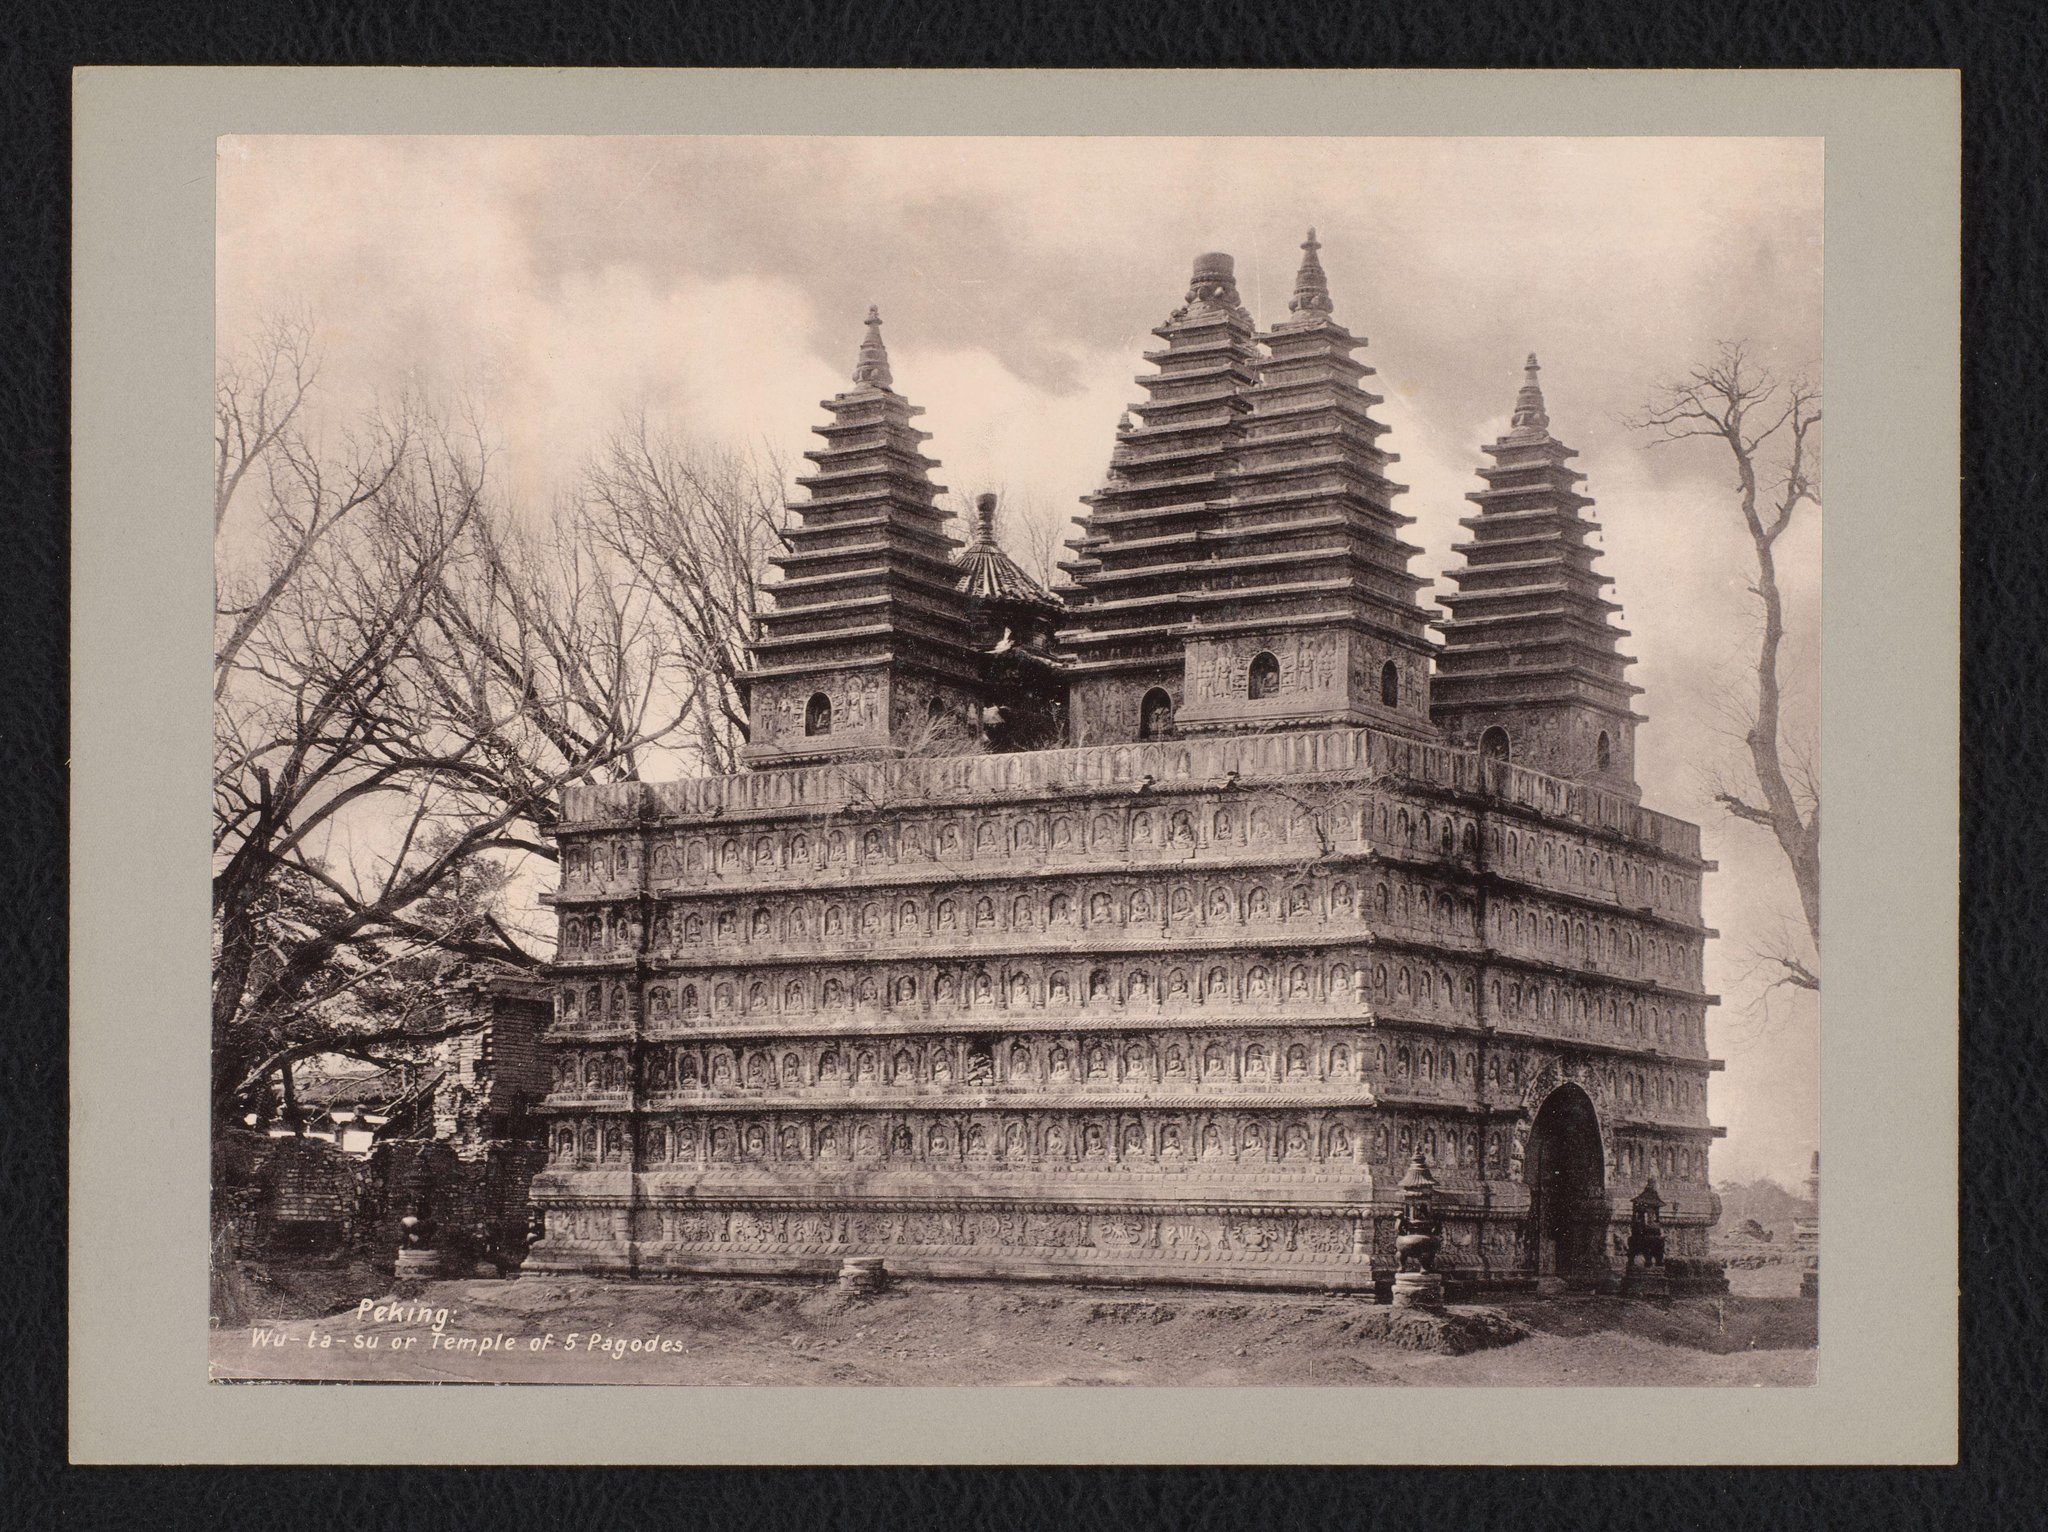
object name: photograph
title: Peking: Wu-ta-su or Temple of 5 Pagodes.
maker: Anonymous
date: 1895-1915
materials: cardboard, photographic support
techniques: photograph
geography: beijing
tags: peking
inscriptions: number: ‘12.’